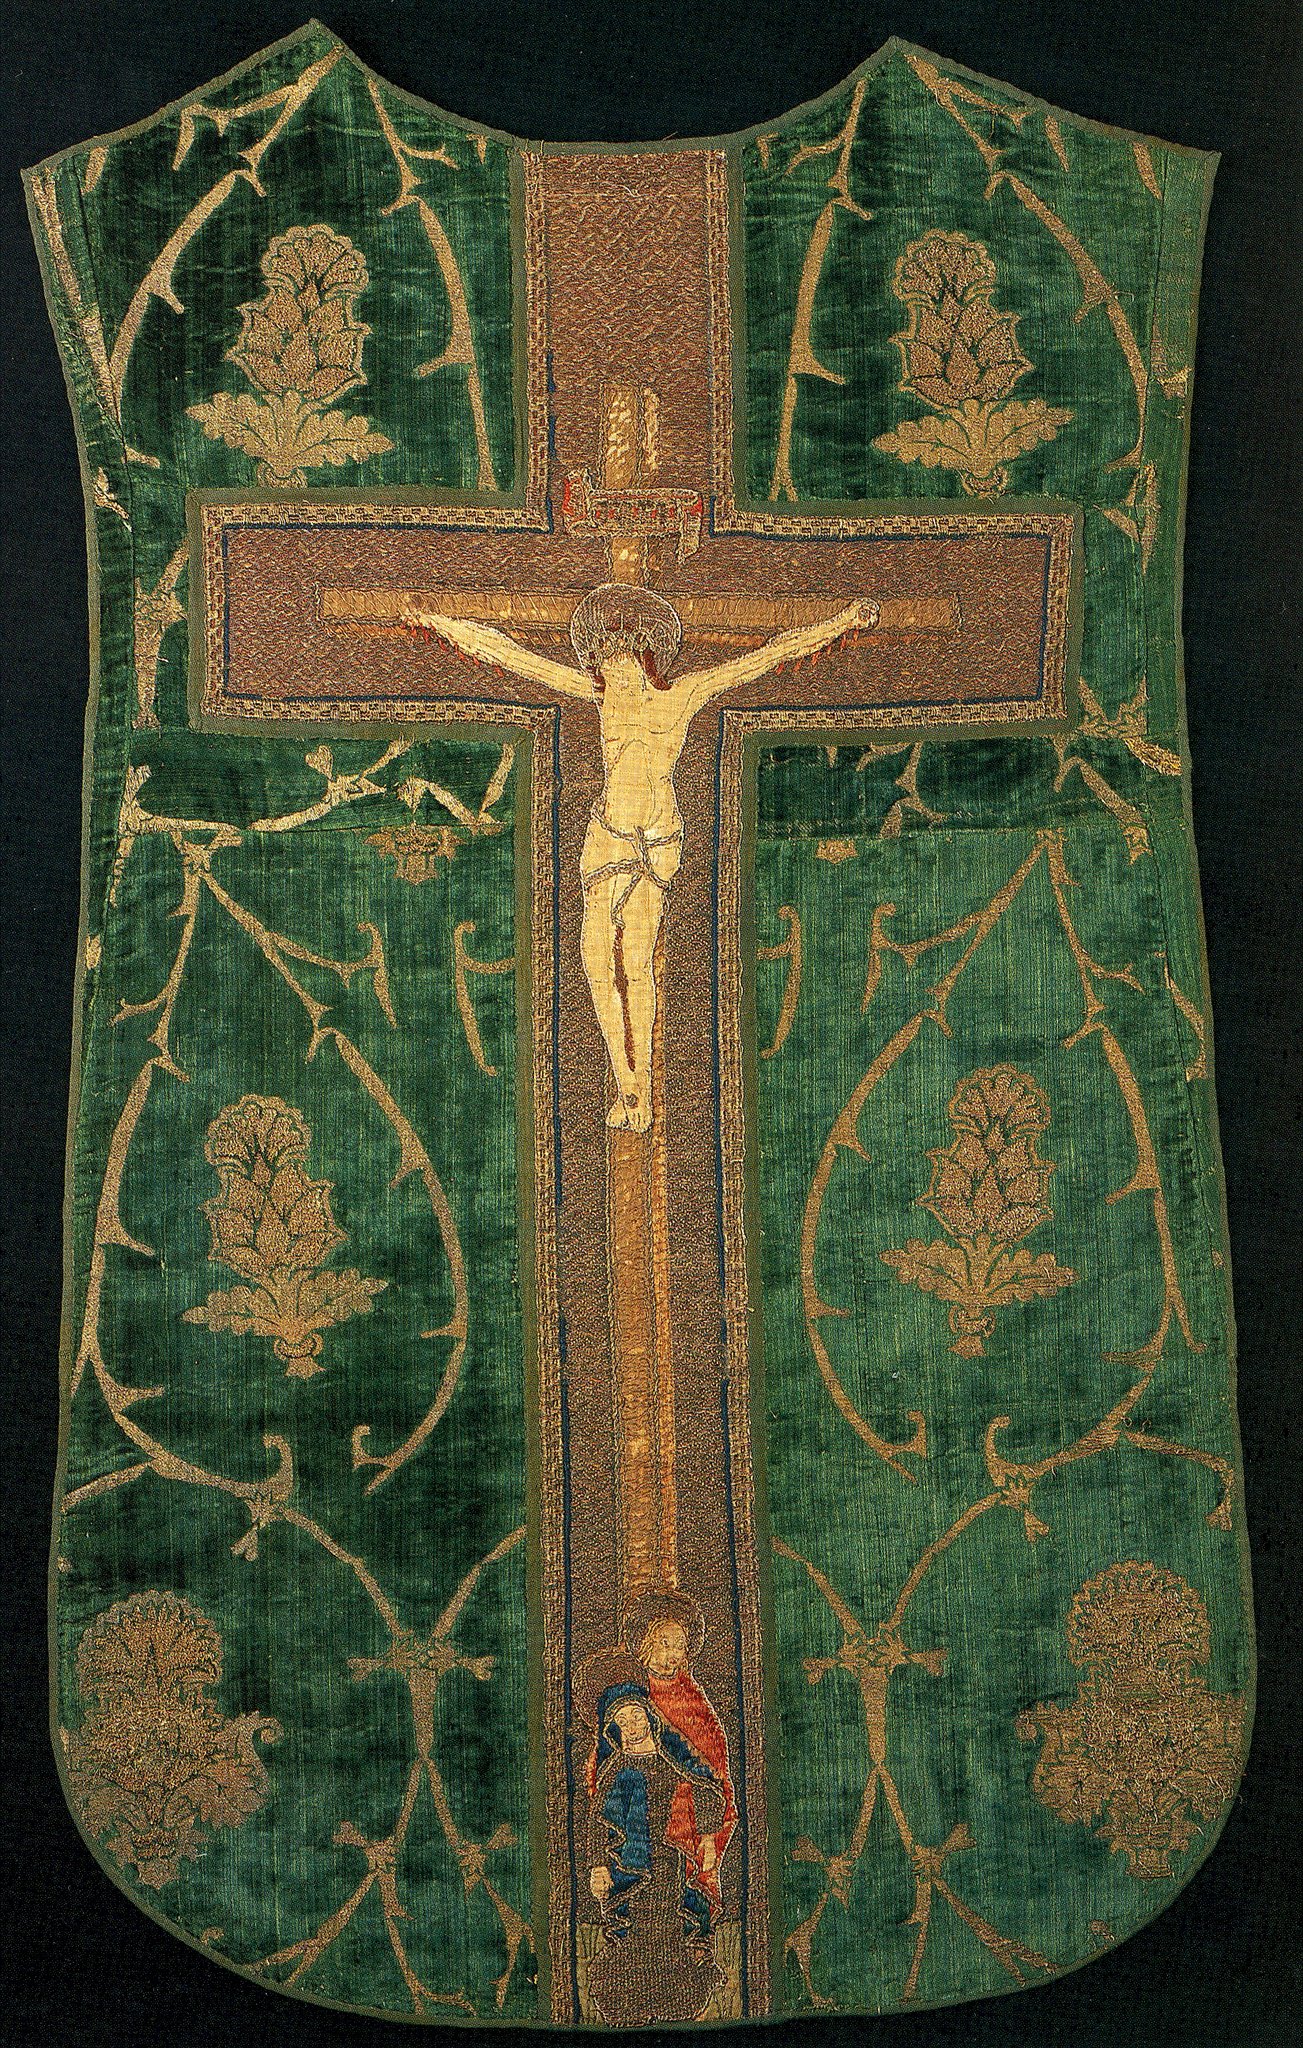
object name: chasuble with orphrey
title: Chasuble Back with an Orphrey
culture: italian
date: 1401-1500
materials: animal substrate, cotton, gilt, hemp, linen, metal, metal thread, silk, wool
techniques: appliqué, bookbinding, brocade, glazing, lining, weave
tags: christ,crucifixion